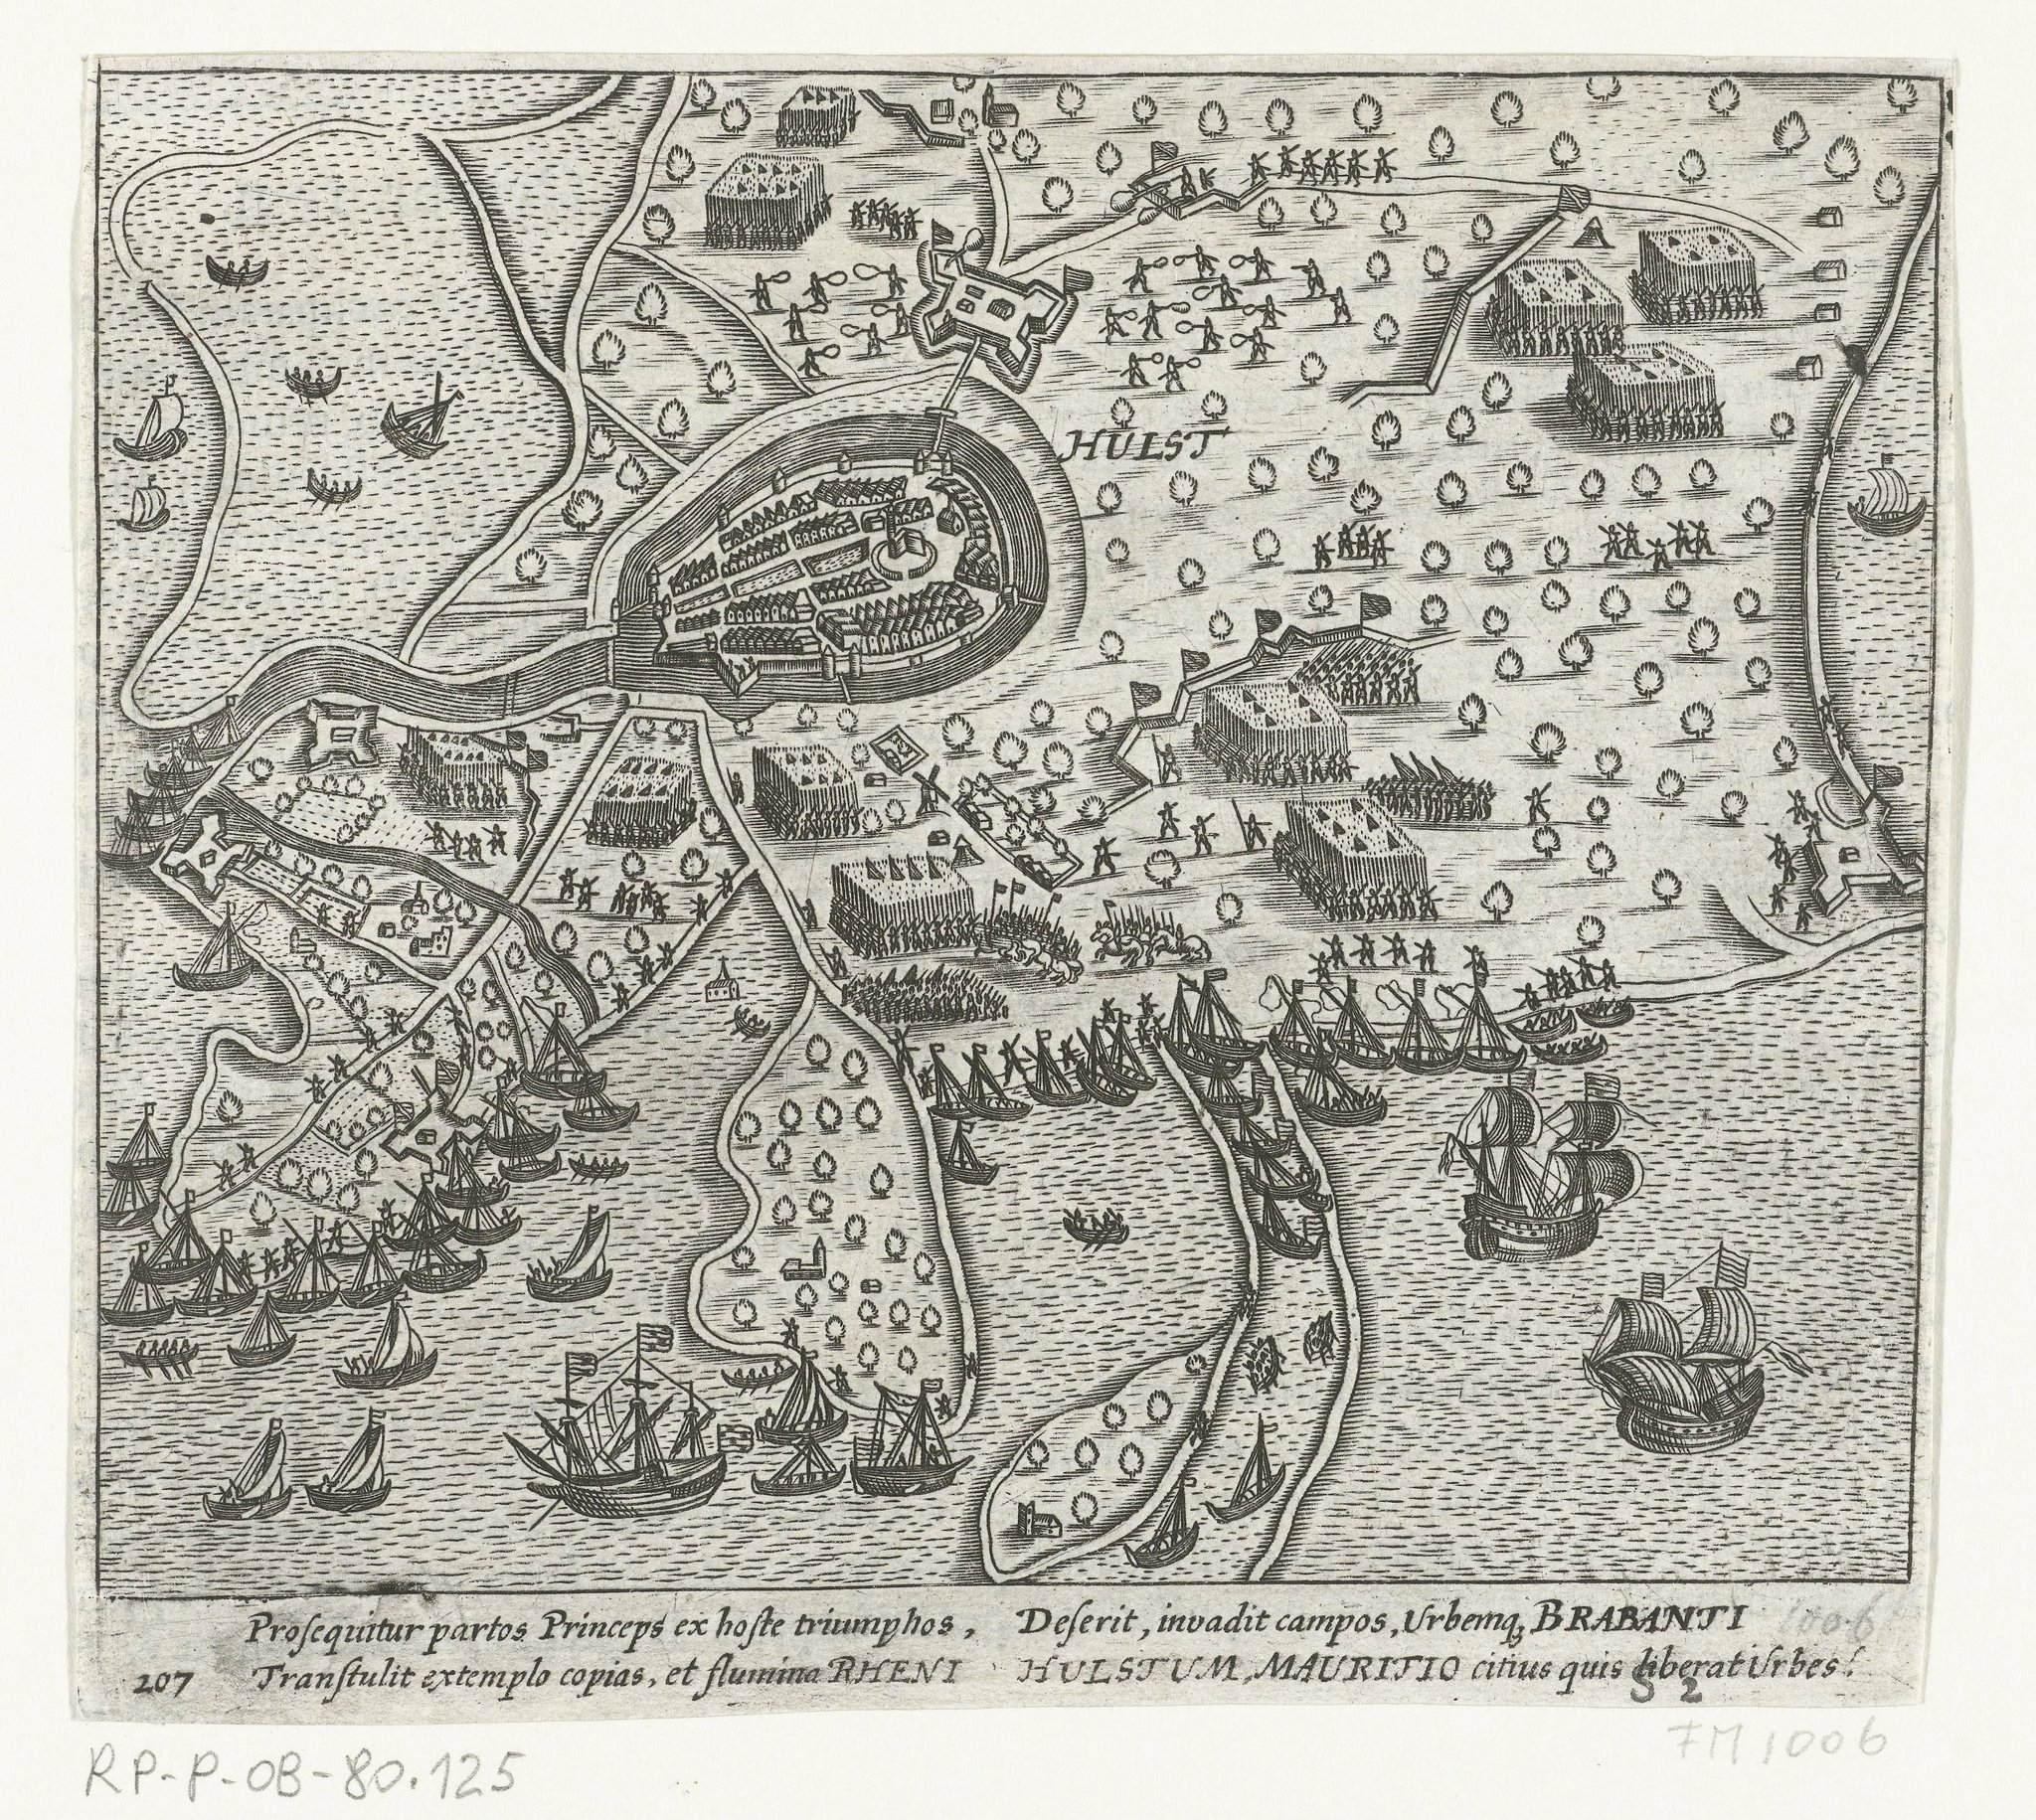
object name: history print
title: Beleg en inname van Hulst door Maurits, 1591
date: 1613-1615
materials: paper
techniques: etching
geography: northern netherlands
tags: maurice (prince of orange), siege, position war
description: Beleg en inname van Hulst door het Staatse leger onder Maurits, 25 september 1591. Plan van Hulst en het omringende land en water, onderaan de vloot bij de haven. Met onderschrift van 4 regels in het Latijn. Genummerd 207. Bedrukt op achterzijde met tekst in het Latijn.